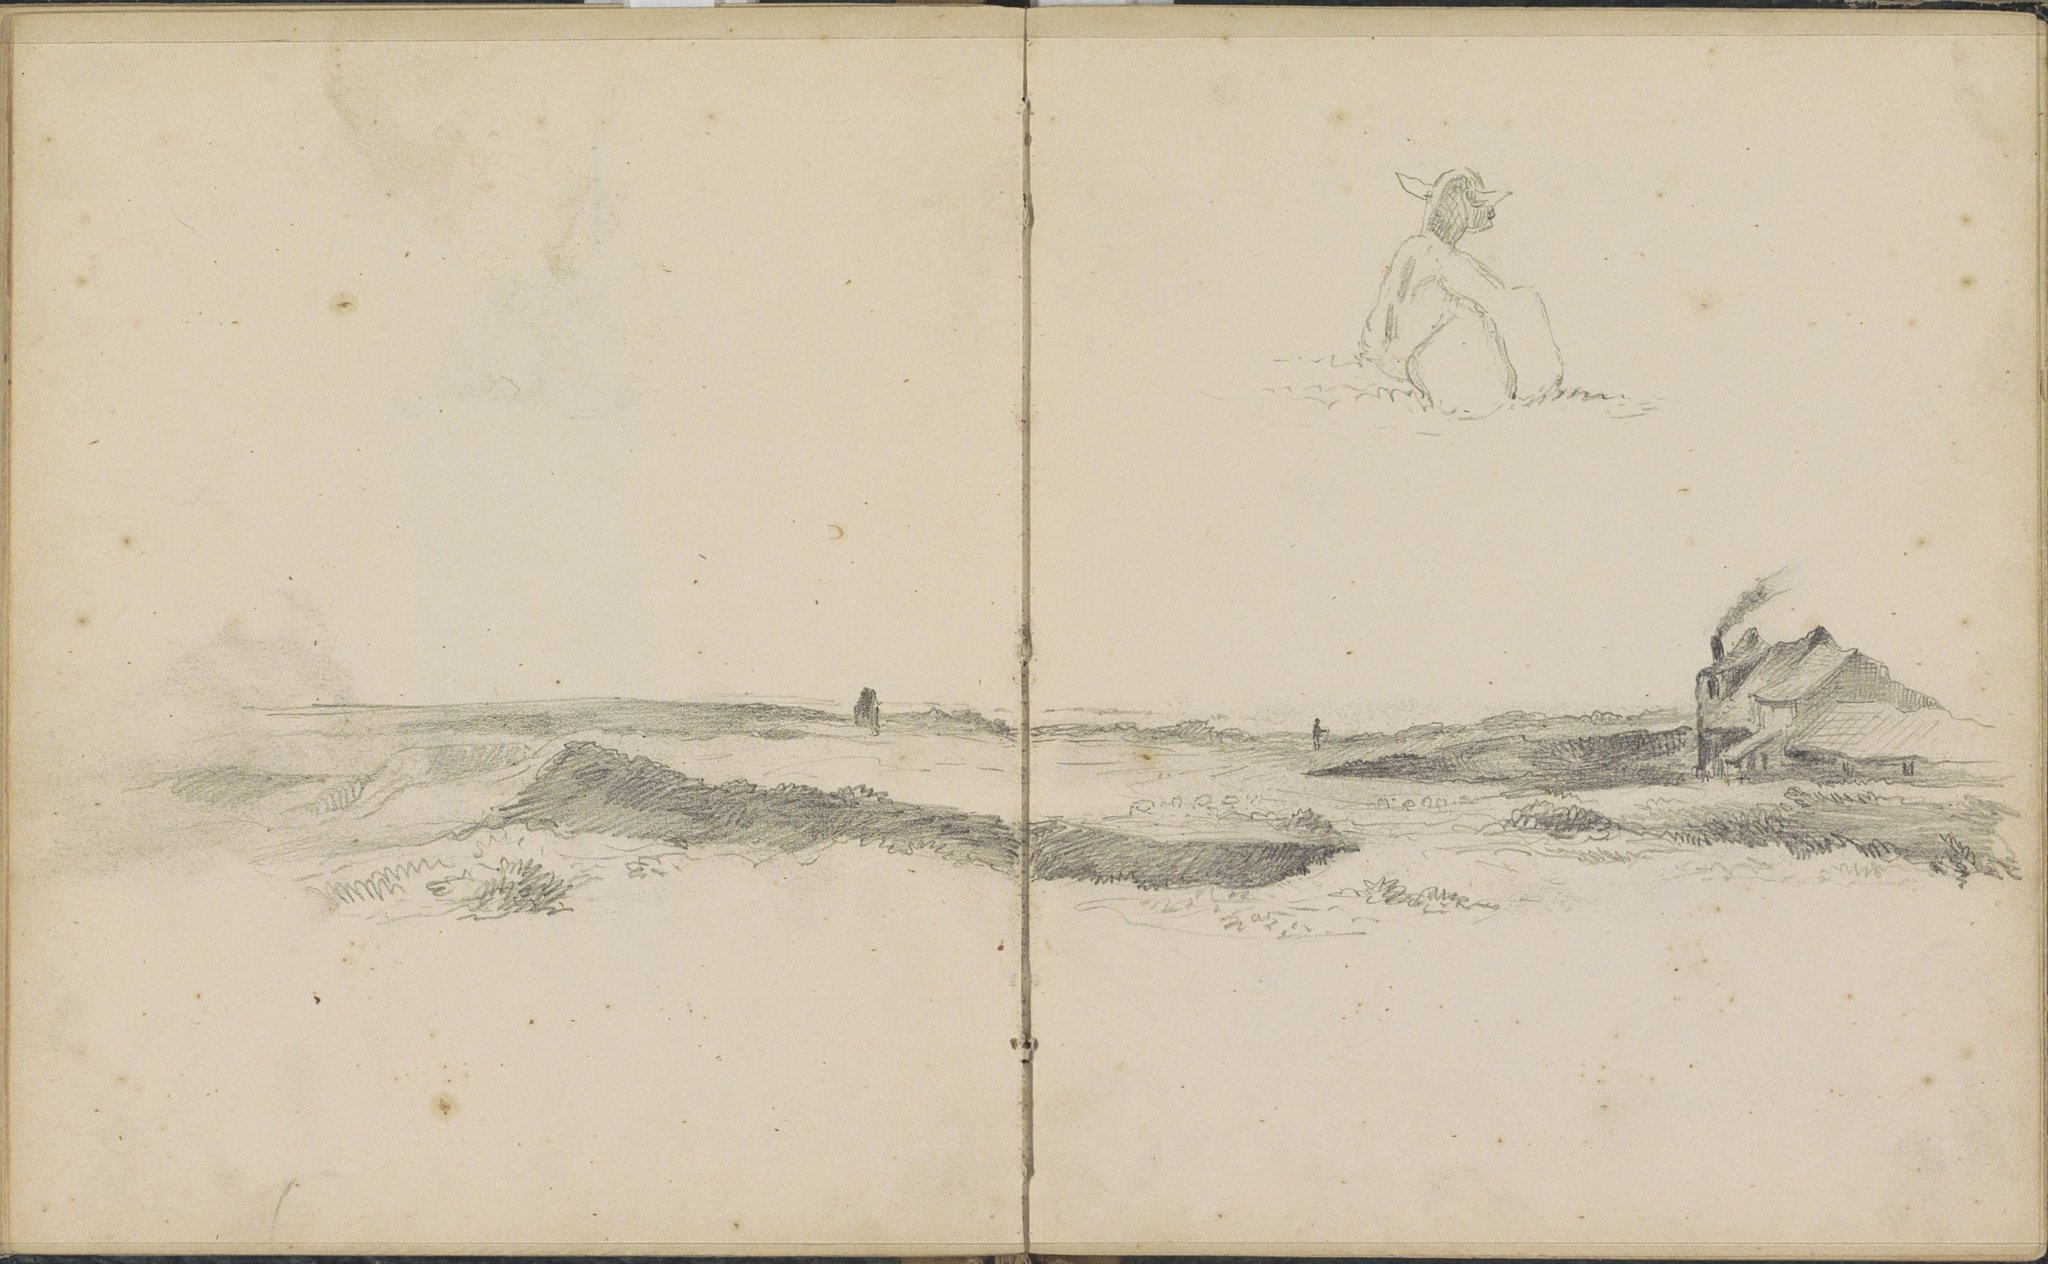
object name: sketchbook leaf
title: Vlak landschap met een huis met rokende schoorsteen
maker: johannes tavenraat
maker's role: draughtsman, painter, print maker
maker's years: 1809-1881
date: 1841-1853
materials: paper, pencil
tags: city-view, and landscape with man-made constructions, cow, rural housing, e.g. country-house, villa, cottage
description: Tevens een studie van een liggende koe in het gras. Blad 44 verso en 45 recto uit een schetsboek met 87 bladen.